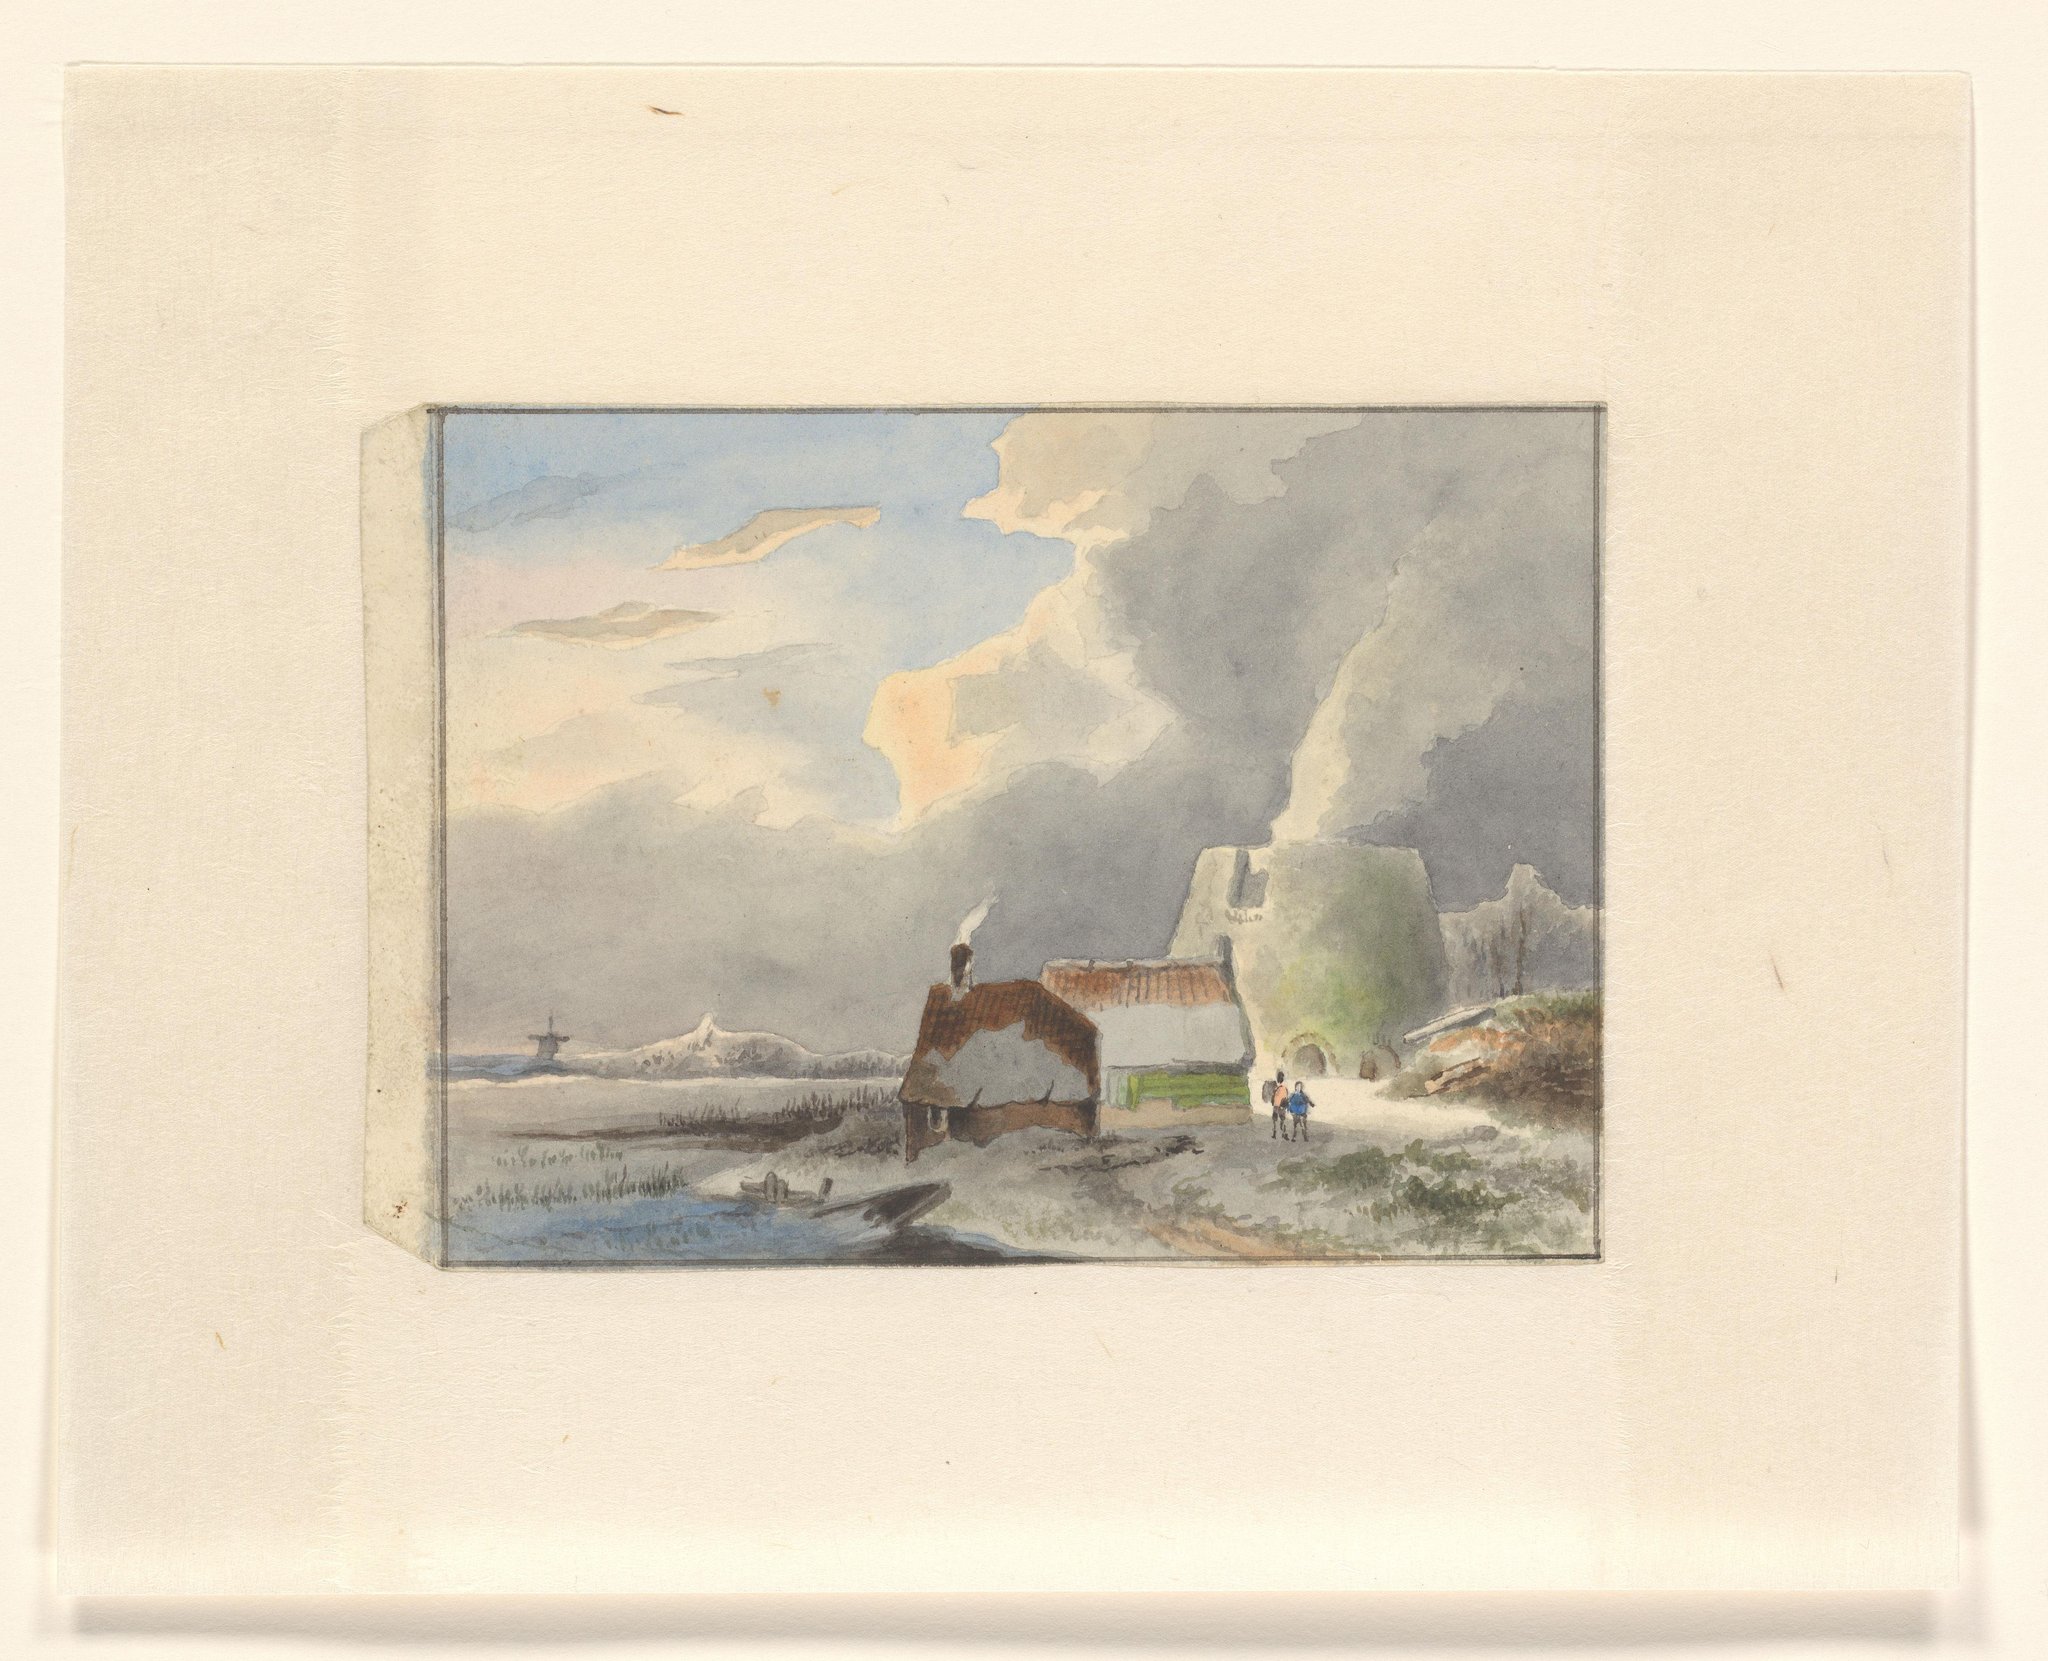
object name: drawing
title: Winterlandschap met kalkoven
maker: johannes van reijn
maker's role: draughtsman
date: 1800-1900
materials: paper, pencil, watercolor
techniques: brush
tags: industries ~ clay, sand, chalk, etc., landscapes